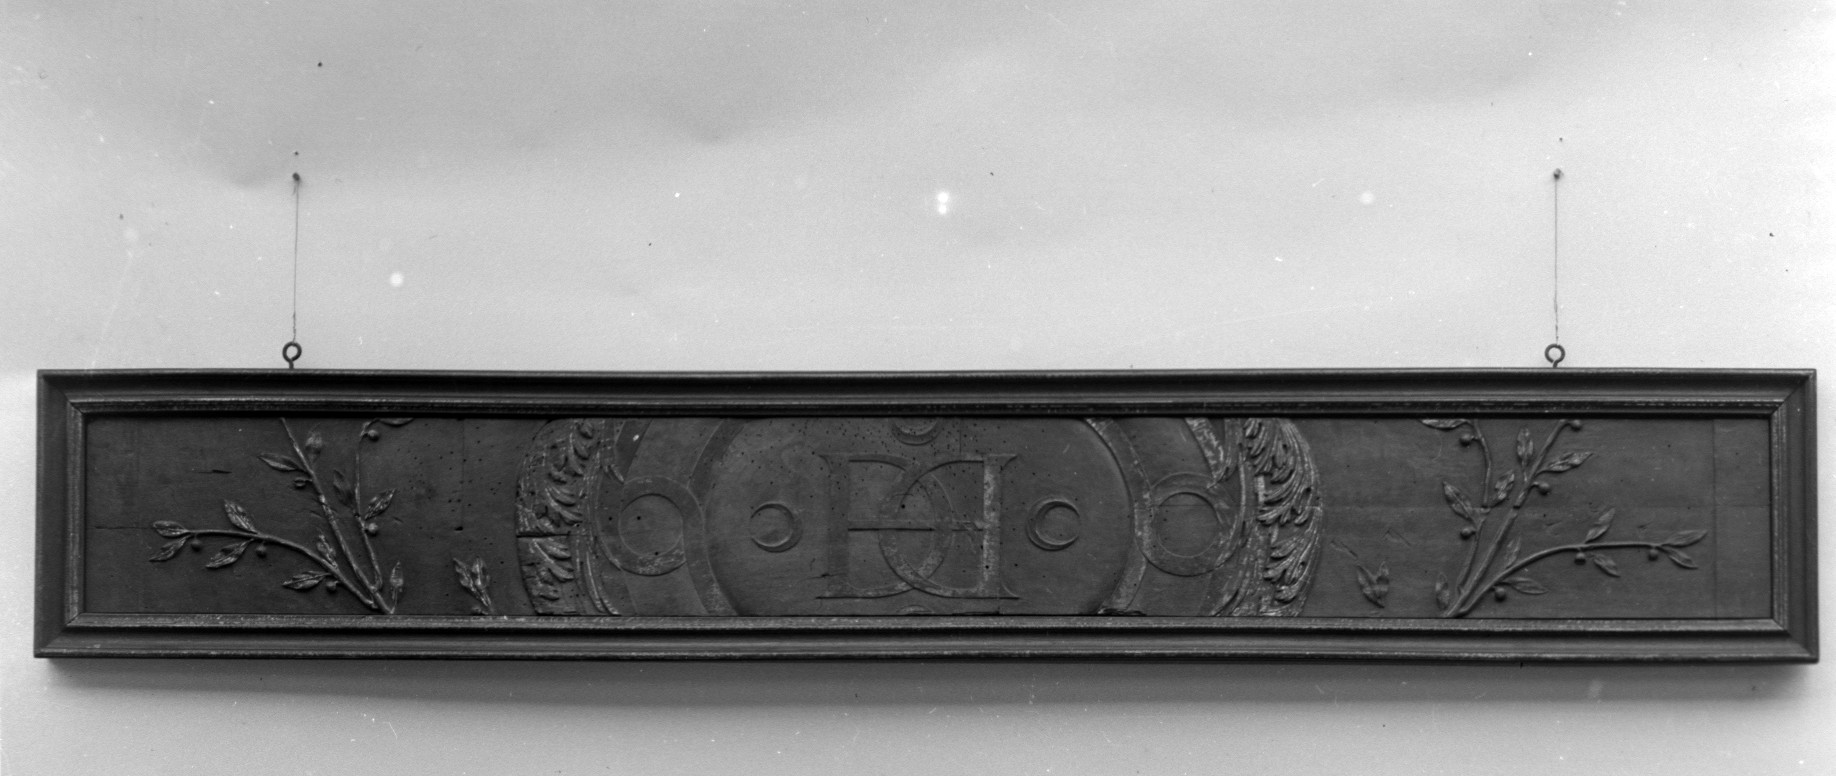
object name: panel fragment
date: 1548-1554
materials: wood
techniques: carving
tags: leaves